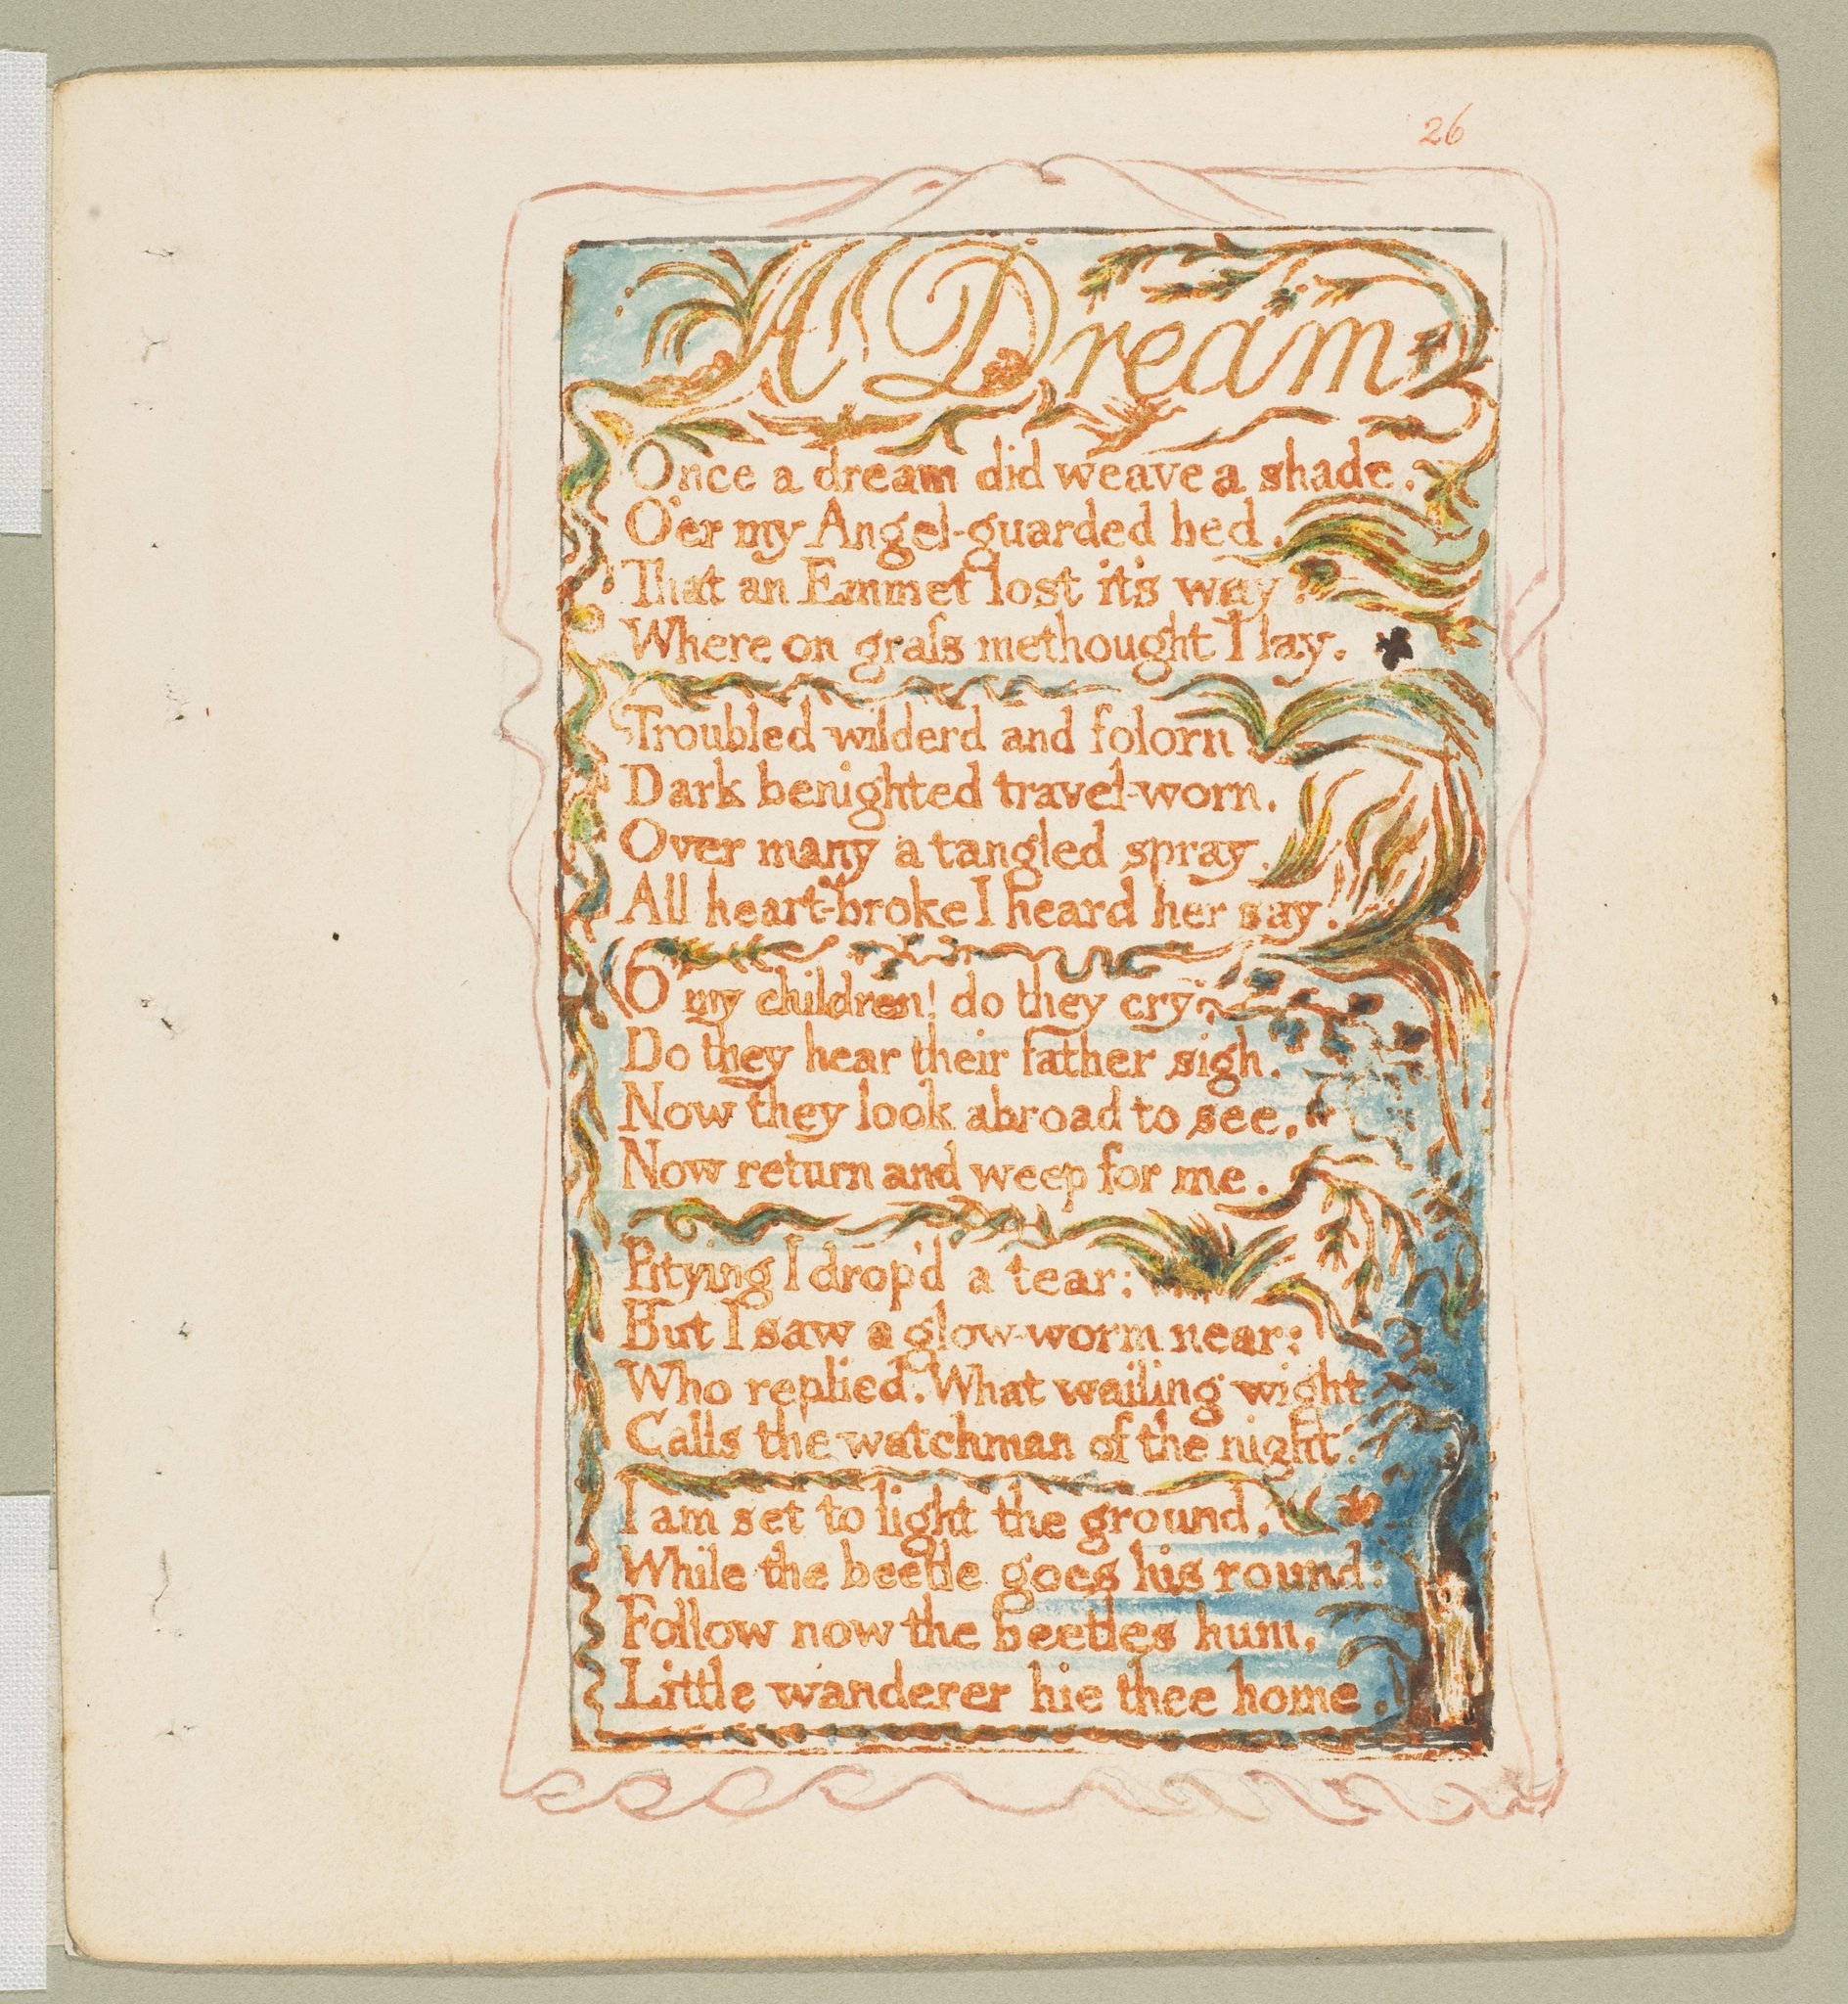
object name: print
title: Songs of Innocence: A Dream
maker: william blake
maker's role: artist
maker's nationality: british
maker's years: 1757-1827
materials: gold, ink, shell, watercolor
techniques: etching, hand coloring, printing, relief